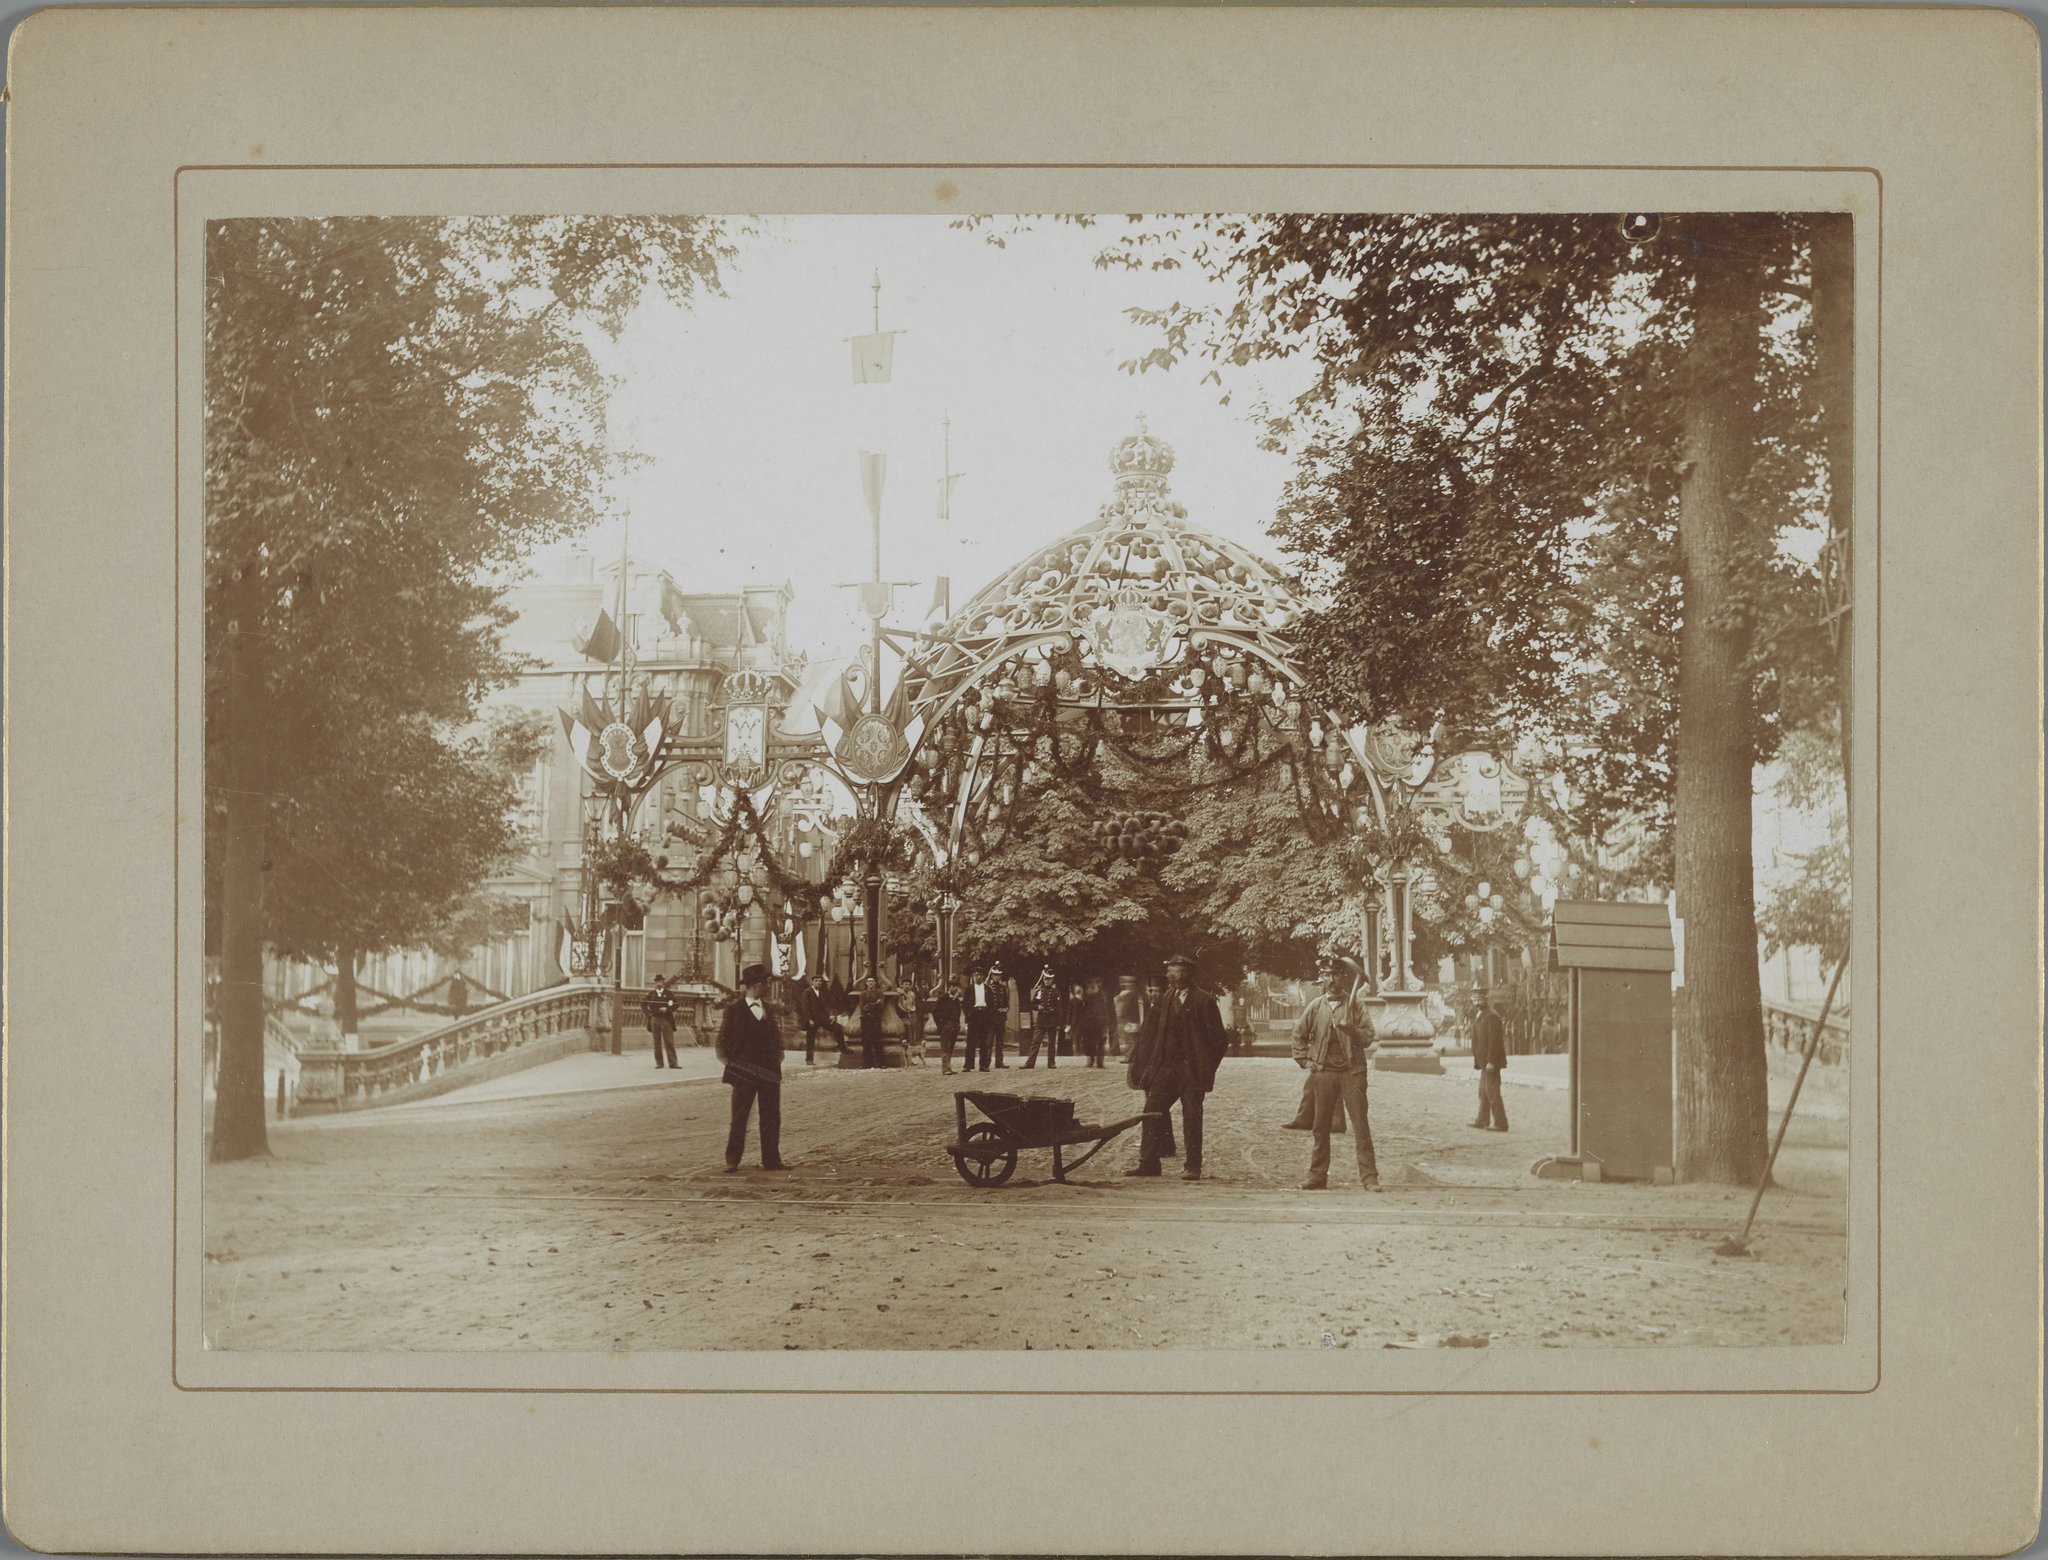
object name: photograph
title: Versieringen in Den Haag ter gelegenheid van de inhuldiging van koningin Wilhelmina, 1898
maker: Anonymous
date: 1898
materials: cardboard, paper, photographic support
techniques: collodion silver print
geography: the hague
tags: print maker, wilhelmina of the netherlands, public festivities at other royal events, not meant or mentioned above (+ festive decoration ~ festive activities), the hague, amsterdam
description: Versieringen in Den Haag ter gelegenheid van de inhuldiging van koningin Wilhelmina, 6 september 1898.